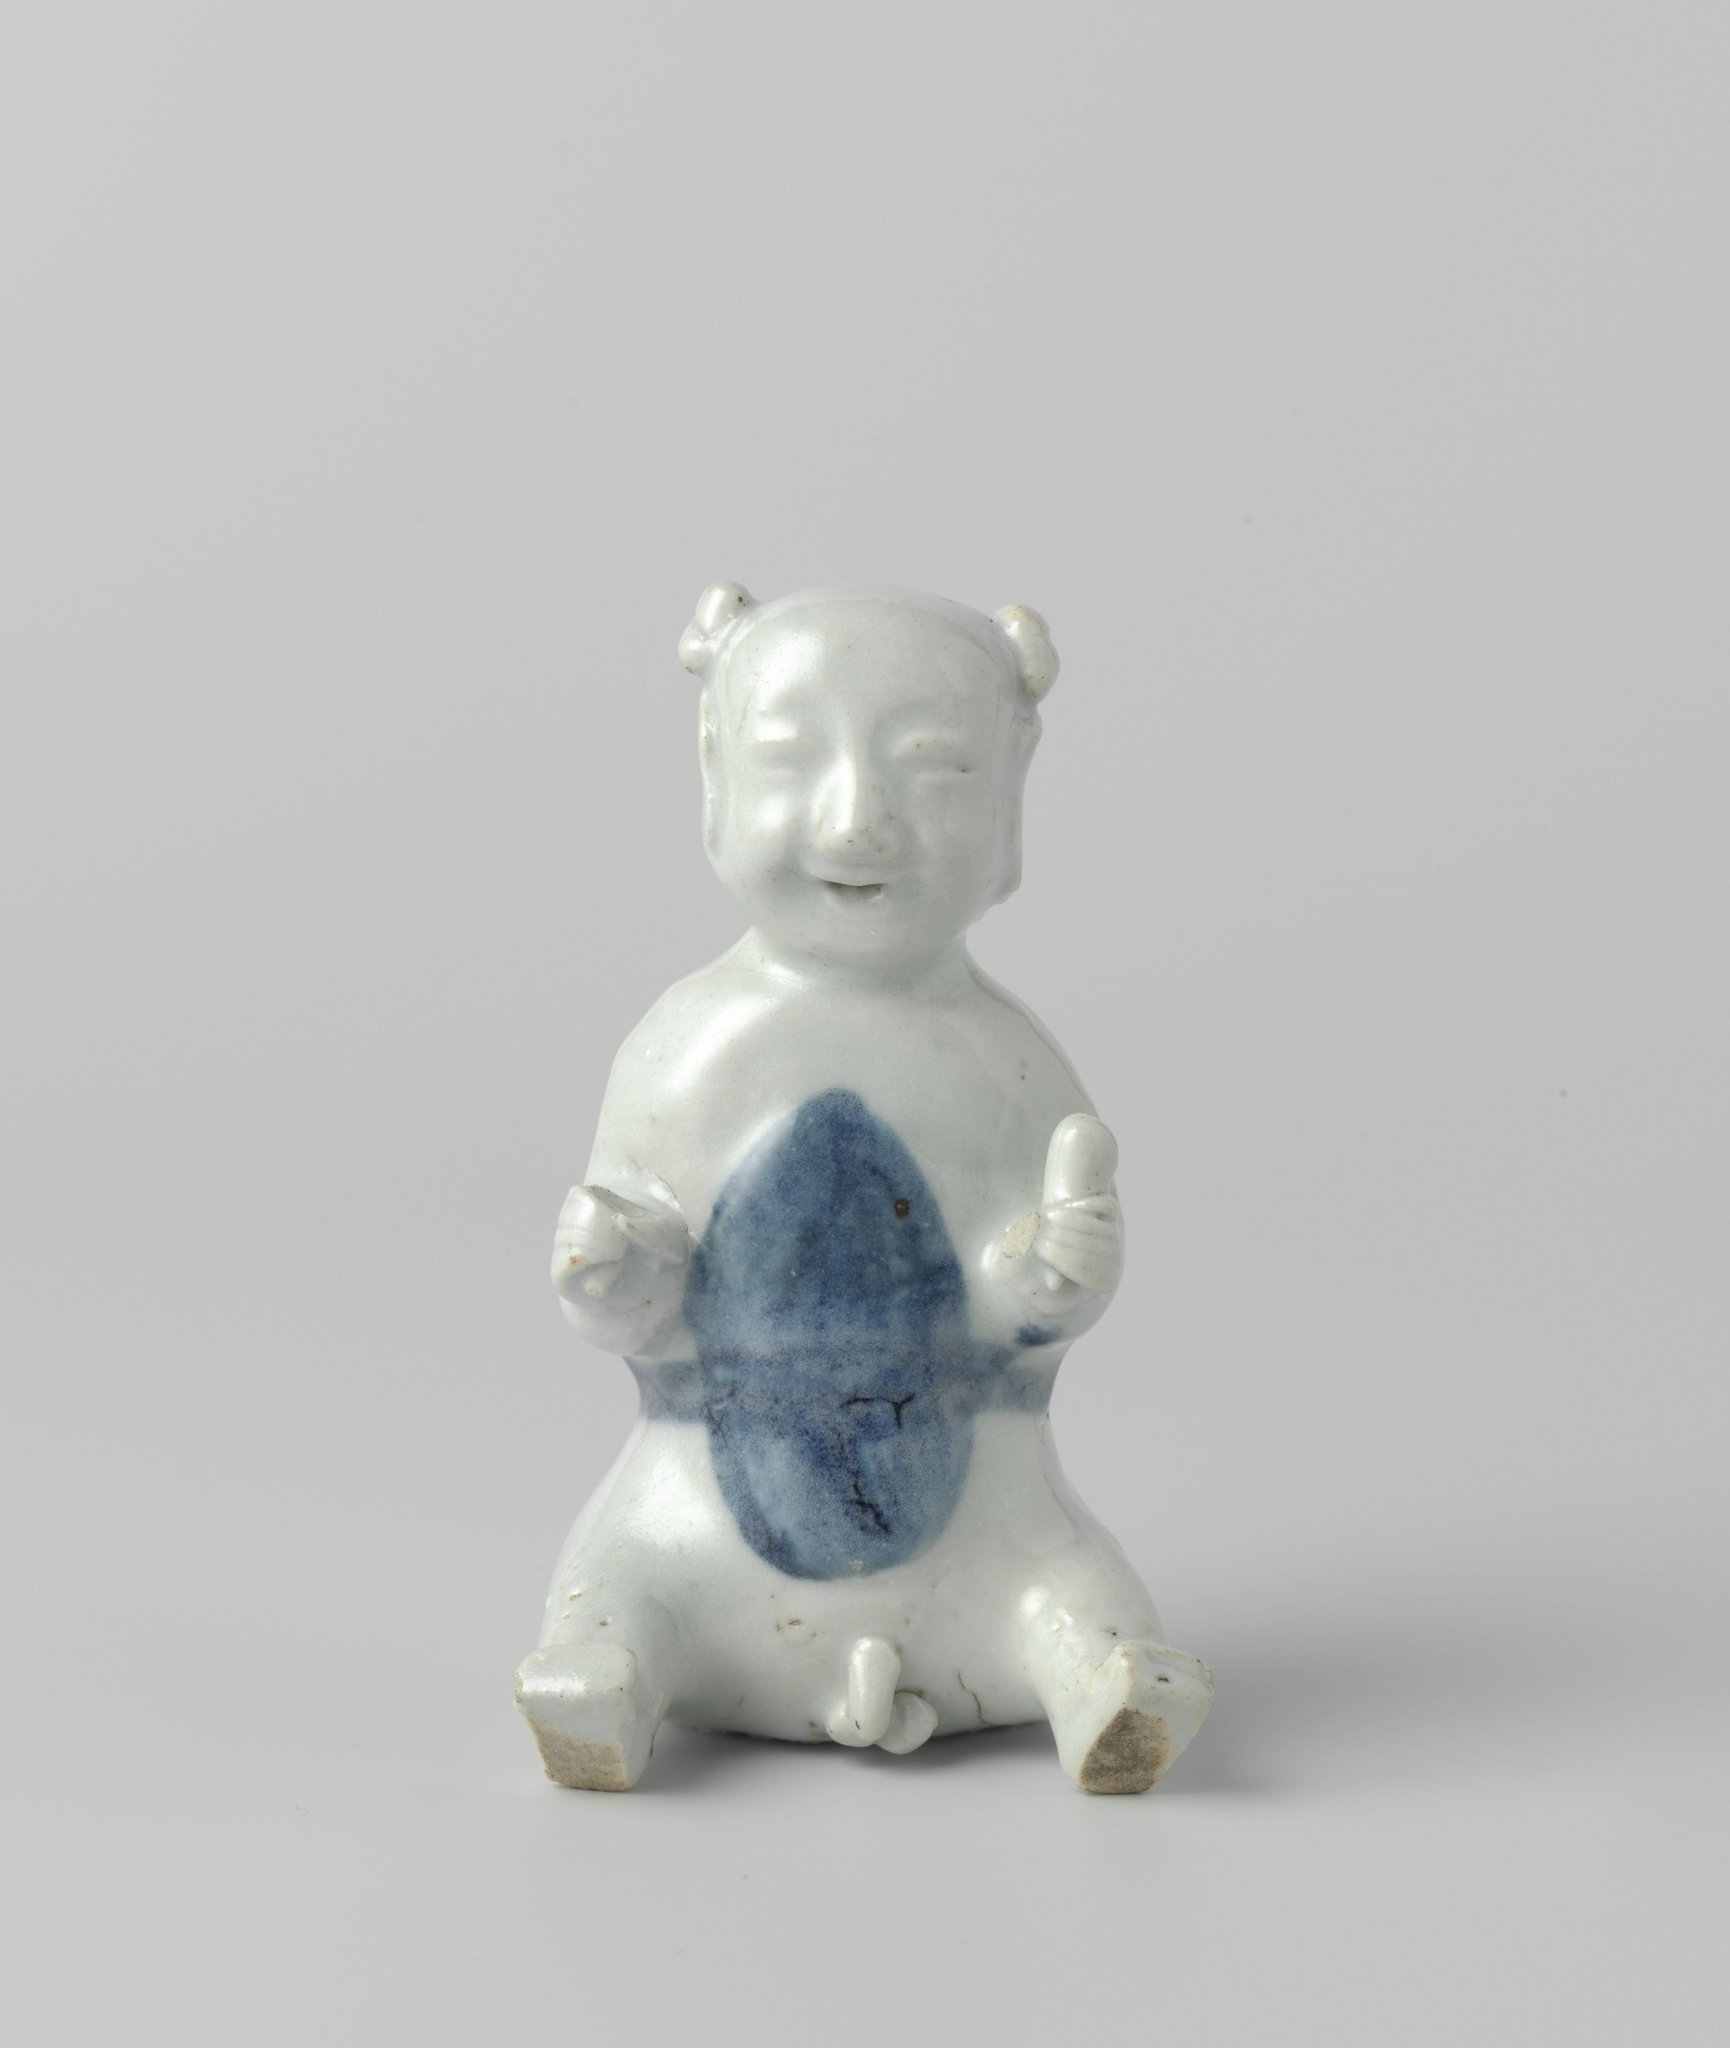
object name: figure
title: Figure of a seated boy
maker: Anonymous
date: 1573-1619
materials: cobalt, glaze, paint, porcelain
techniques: firing, forming, vitrification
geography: china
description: Beeld van porselein, beschilderd in onderglazuur blauw. Een zittende jongen (zotje). Blauw-wit.